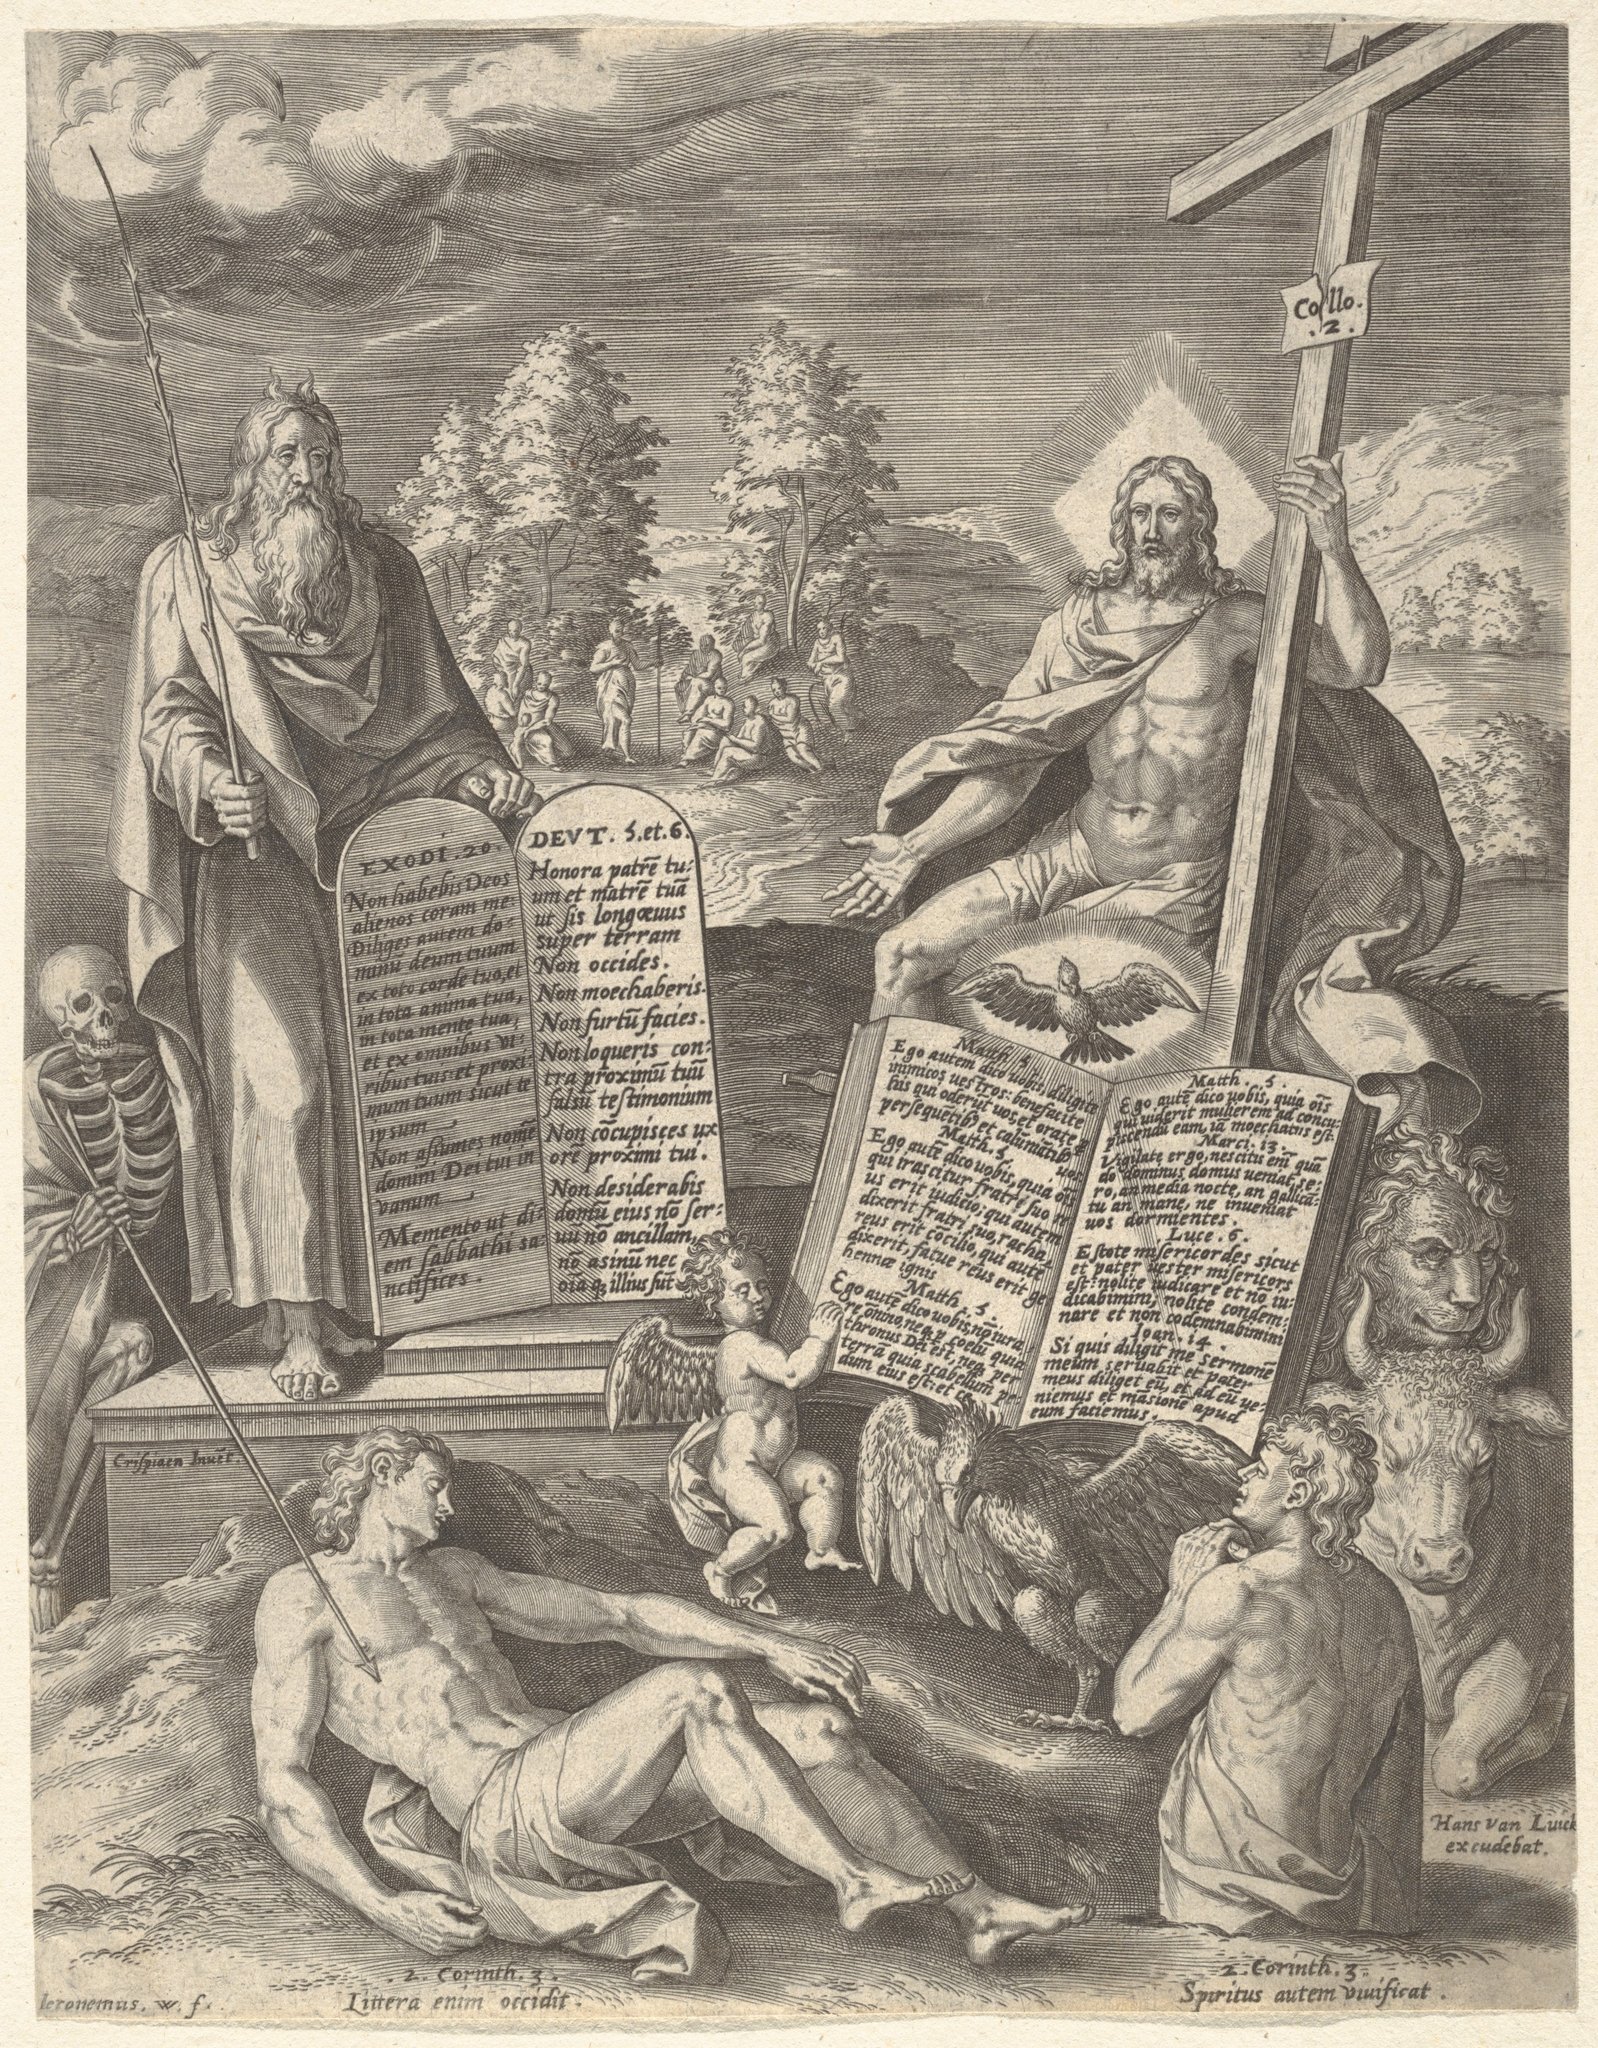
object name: print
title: Allegory of the Salvation of Mankind from "Allegory of the Resurrection and the Salvation," a pair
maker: hieronymus wierix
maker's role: artist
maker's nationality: netherlandish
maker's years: 1553-1619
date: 1586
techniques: engraving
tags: eagles,men,angels,christ,cross